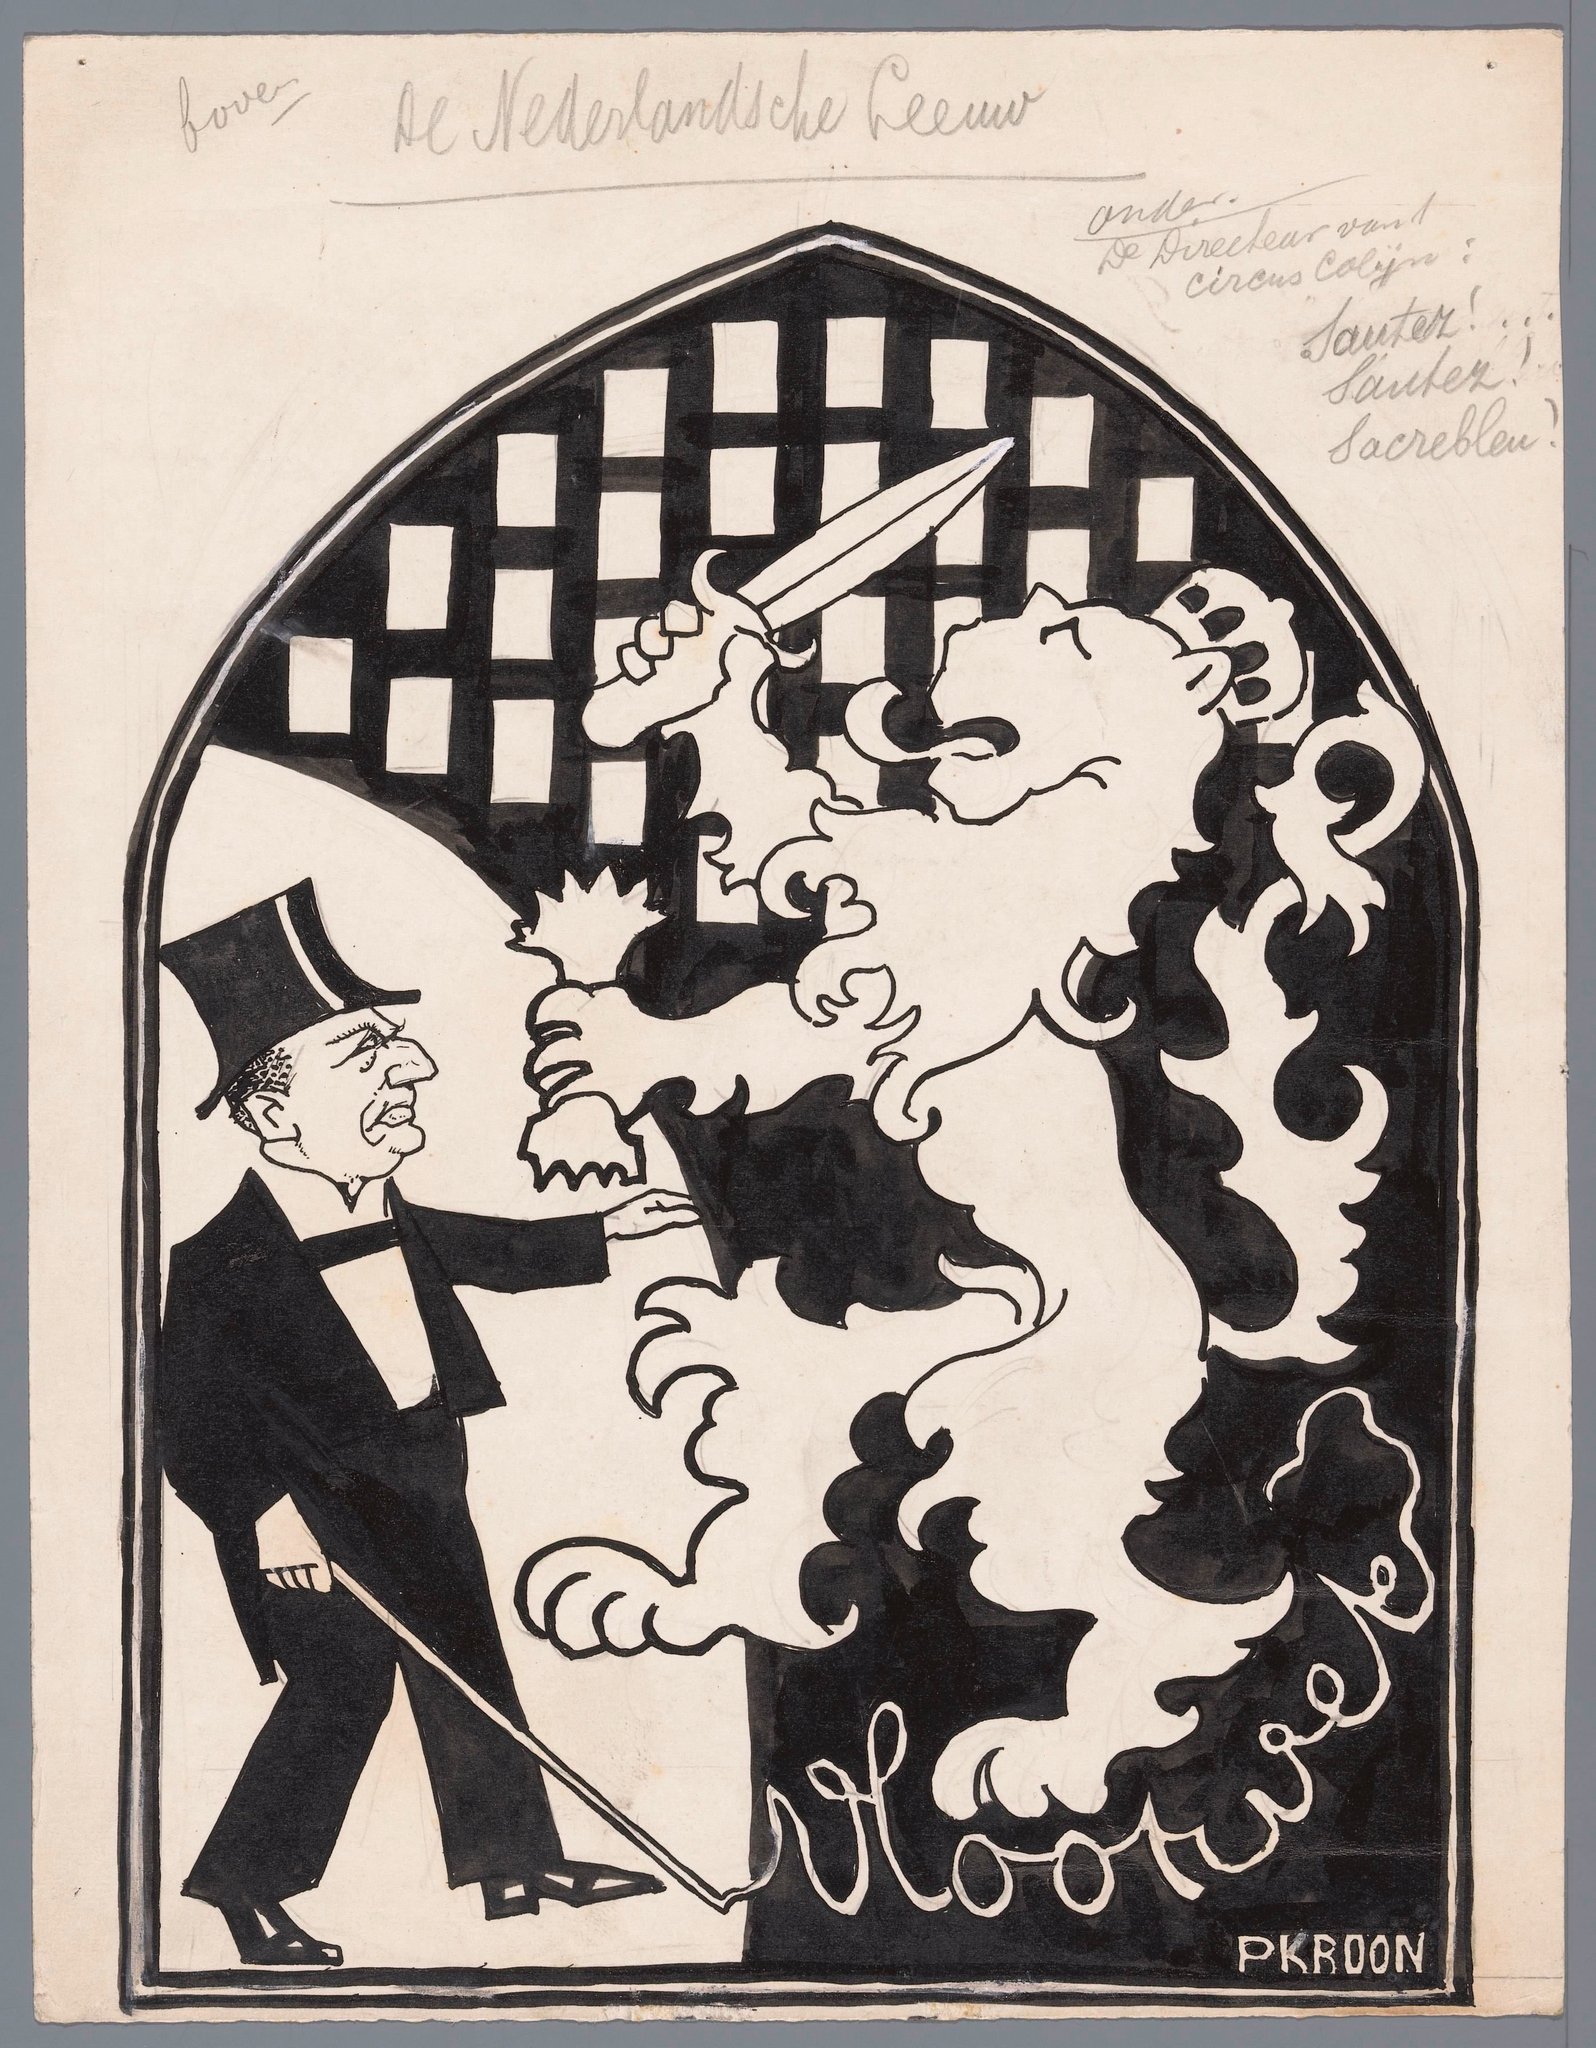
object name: drawing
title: De Nederlandsche Leeuw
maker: patricq kroon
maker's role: draughtsman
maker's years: 1862-1941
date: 1912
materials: paper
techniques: brush, pen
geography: netherlands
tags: hendrikus colijn, circus animals, personifications of countries, nations, states, districts, etc., boss, director (of circus), political caricatures and satires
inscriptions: number: ‘13861’, inscription: ‘De Nederlandsche Leeuw / De Directeur van het circus Colijn: Sautez! Sautez! Sacrebleu!’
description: Hendrik Colijn als spreekstalmeester van het circus dresseert de Nederlandse Leeuw ivm de vlootwet van 1912. Ontwerp voor een politieke spotprent.